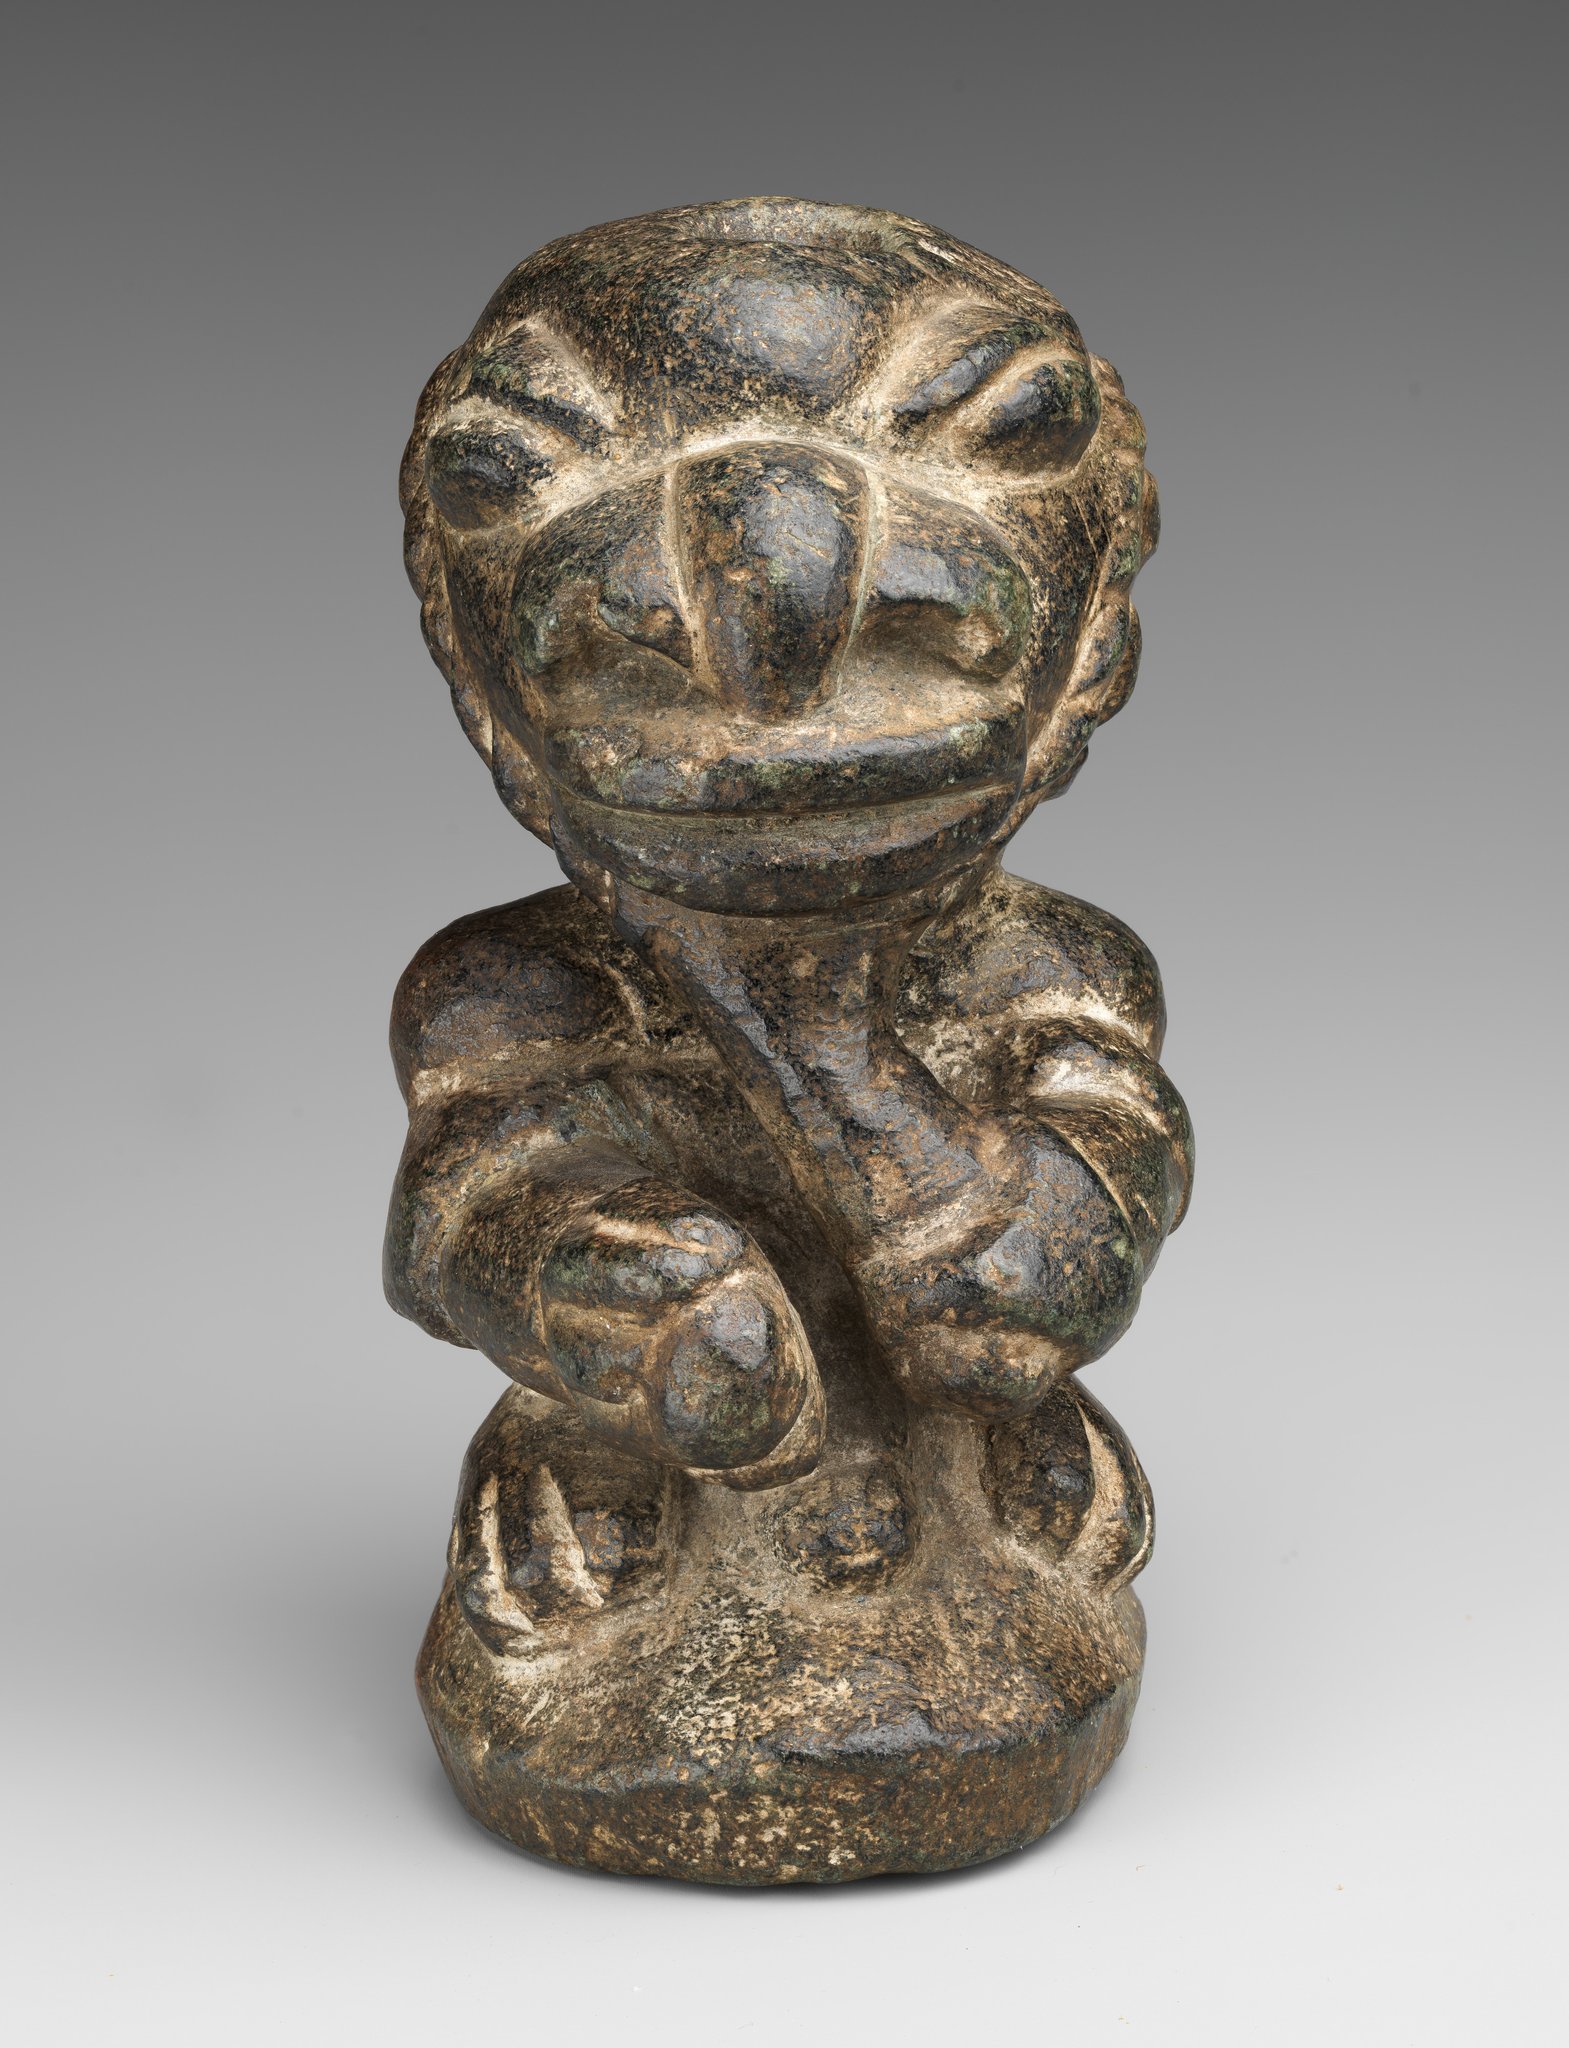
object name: male figure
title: Figure: Seated Male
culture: bullom or temne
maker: temne or bullom artist(s)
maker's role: artist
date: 1501-1600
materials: stone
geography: sierra leone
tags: men